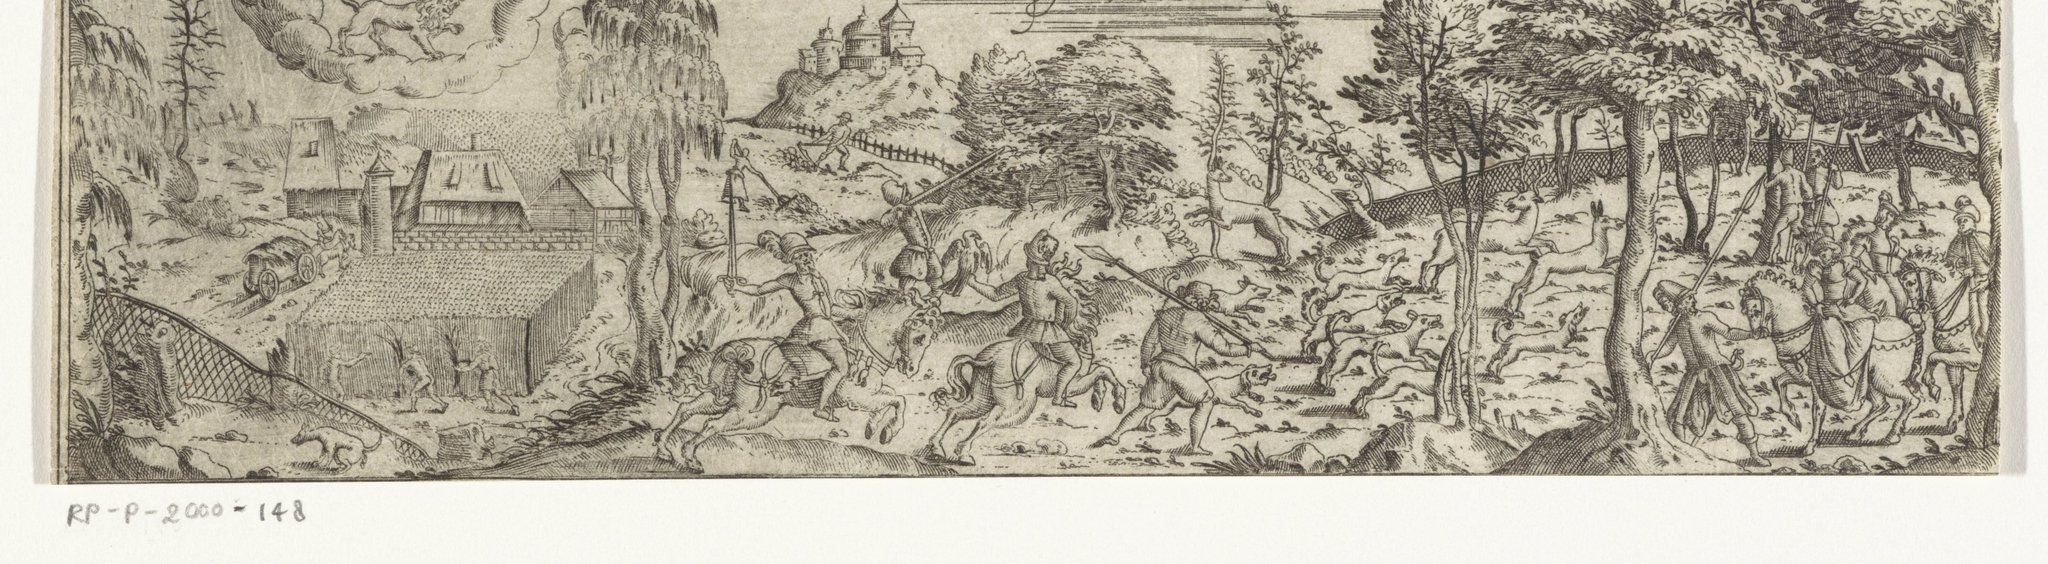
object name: print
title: Twaalf maanden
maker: Anonymous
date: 1554-1641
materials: paper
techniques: etching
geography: netherlands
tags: july and its 'labours' (+ with zodiacal signs)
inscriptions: collector's mark: Lugt 2228, collector's mark: Lugt 2760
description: Bezigheden in de maand juli. Rechts de hertenjacht en links het oogsten van het graan. Linksboven in de lucht het dierenriemteken Leeuw.